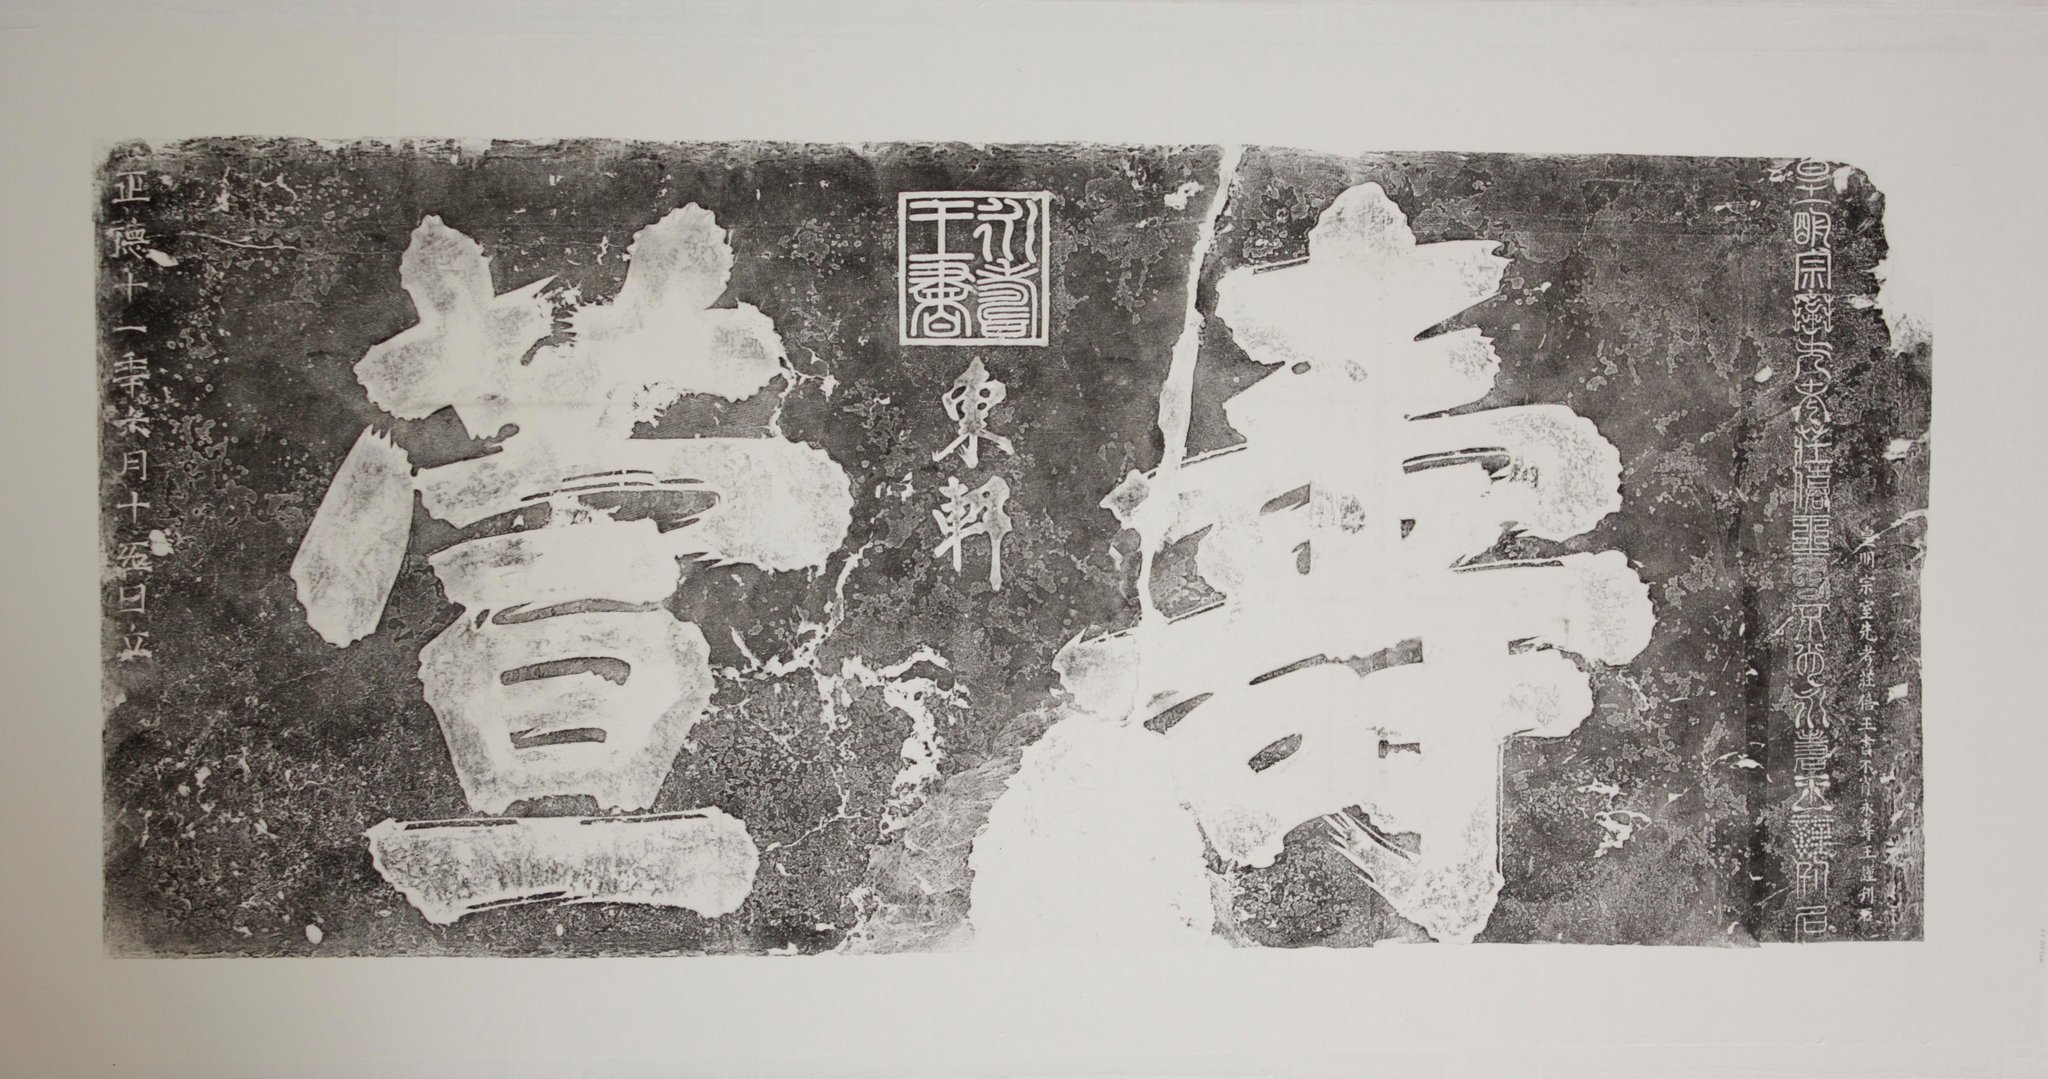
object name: rubbing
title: Placard for Shouxuan Hall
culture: chinese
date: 1901-2000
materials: ink, paper